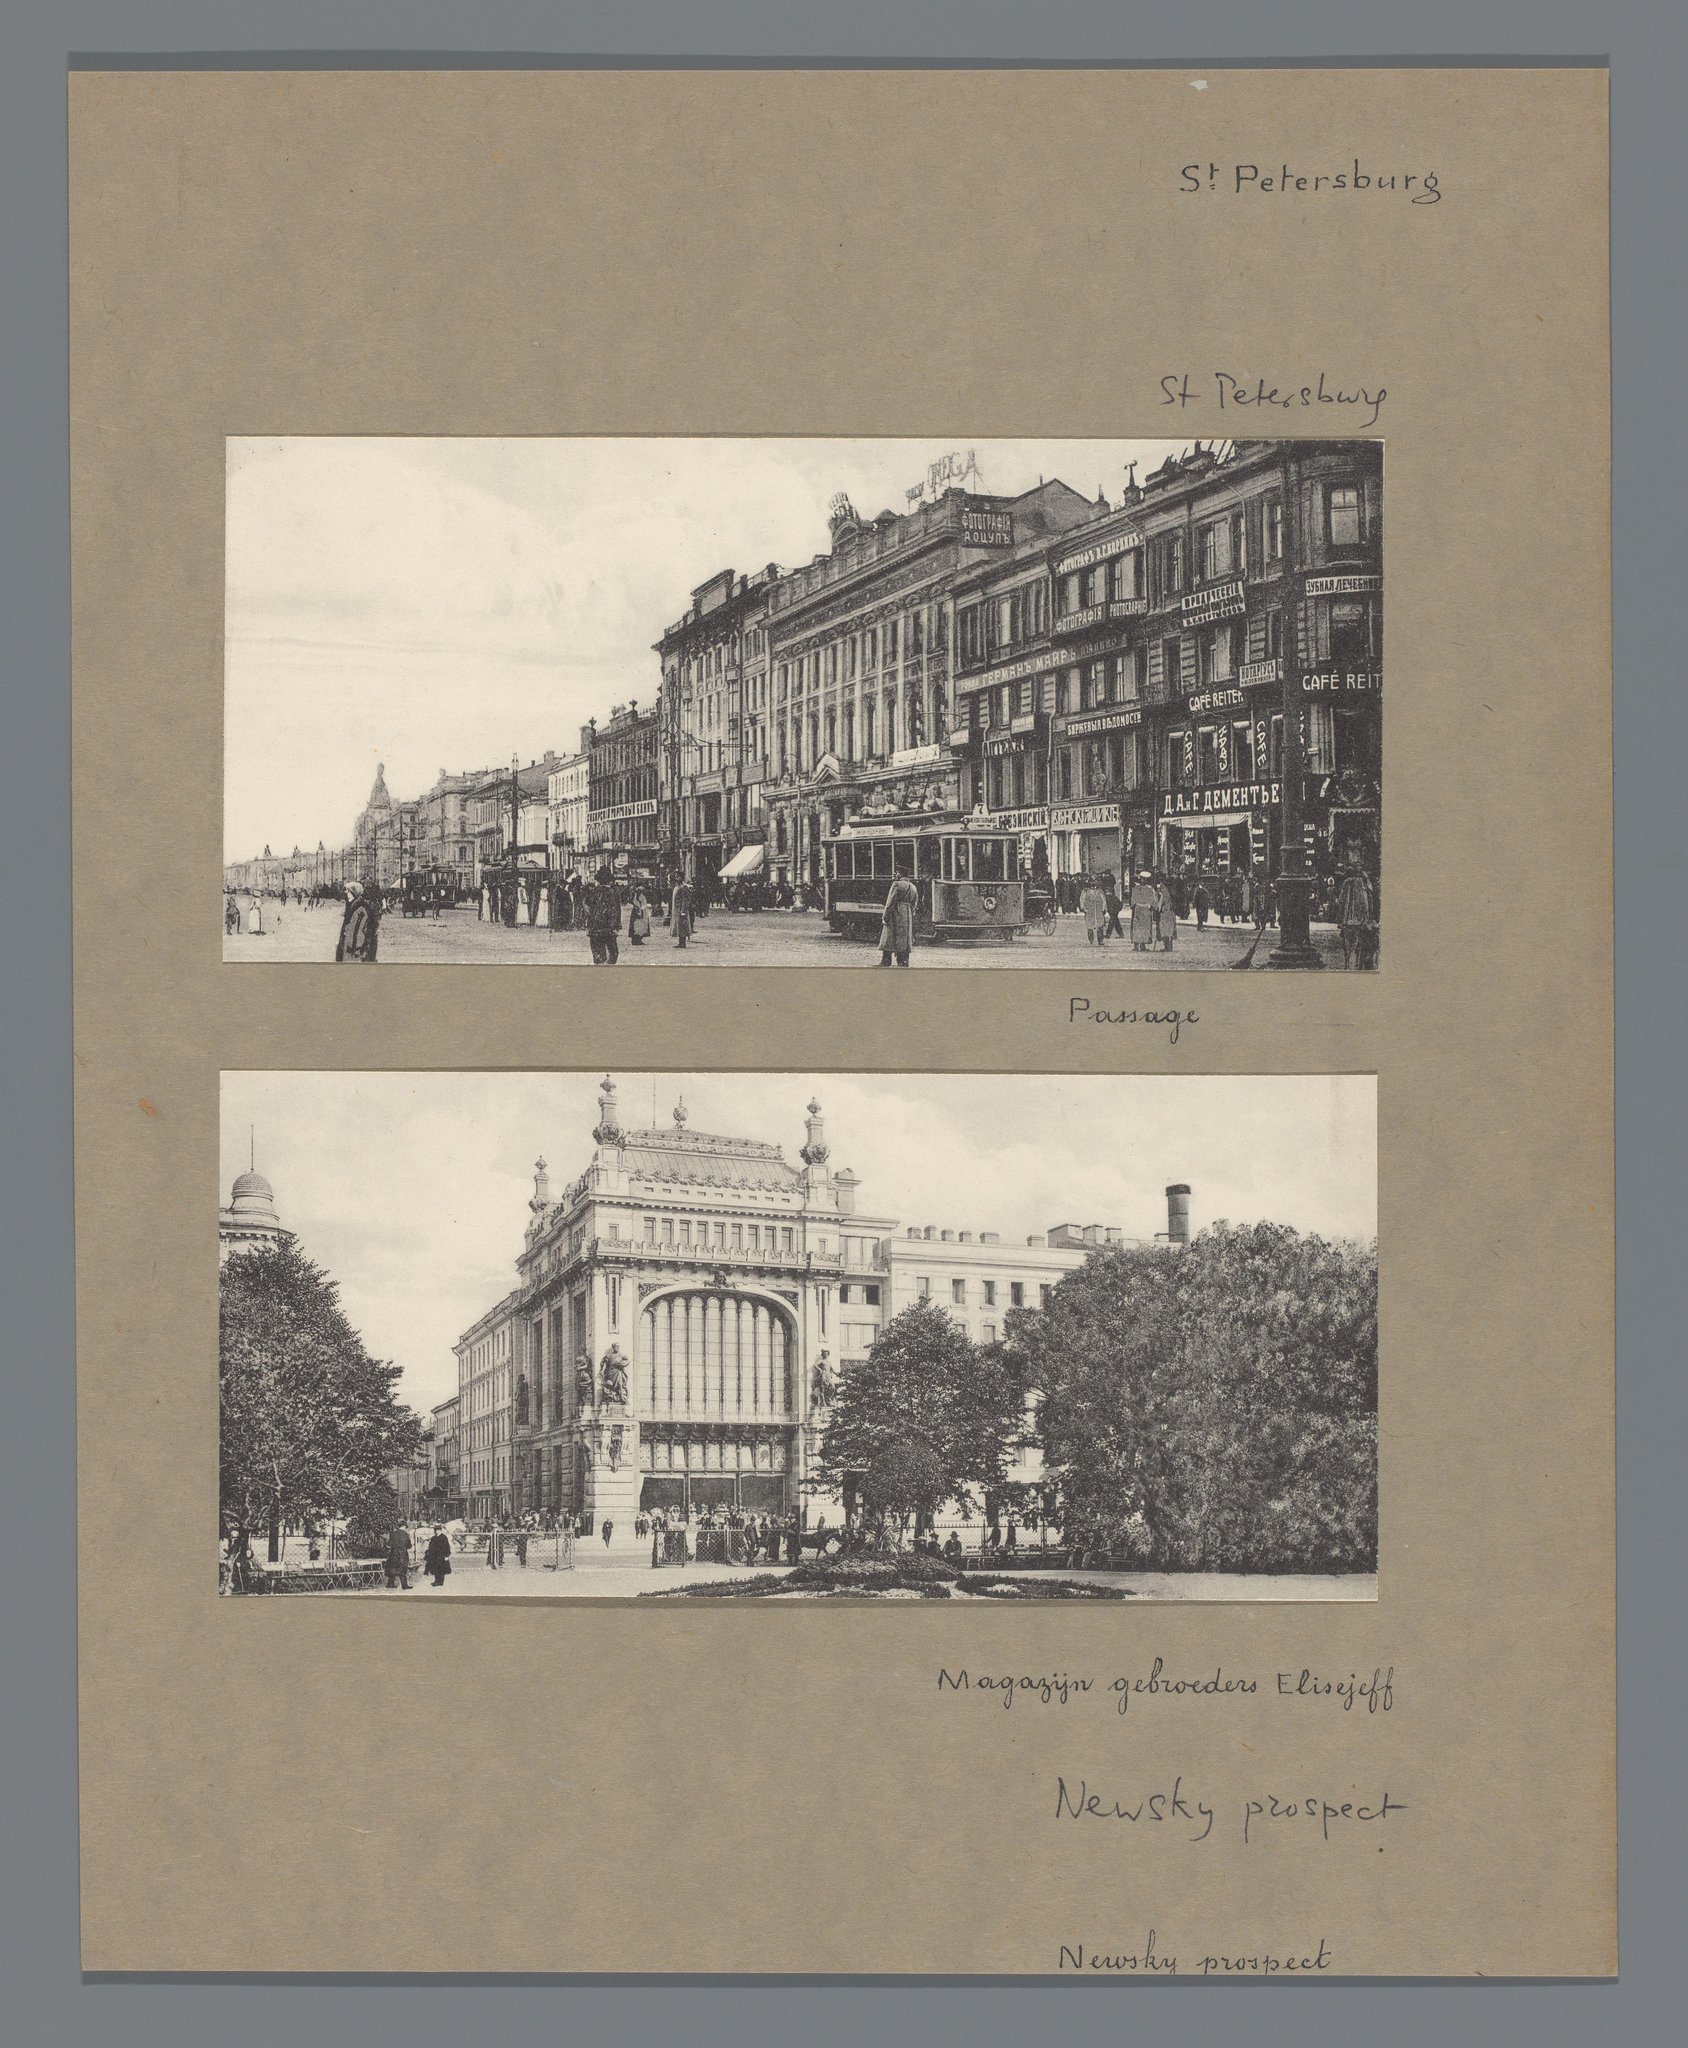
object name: photograph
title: St. Petersburg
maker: Anonymous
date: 1860-1925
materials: photographic support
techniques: photograph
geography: russia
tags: sint-petersburg